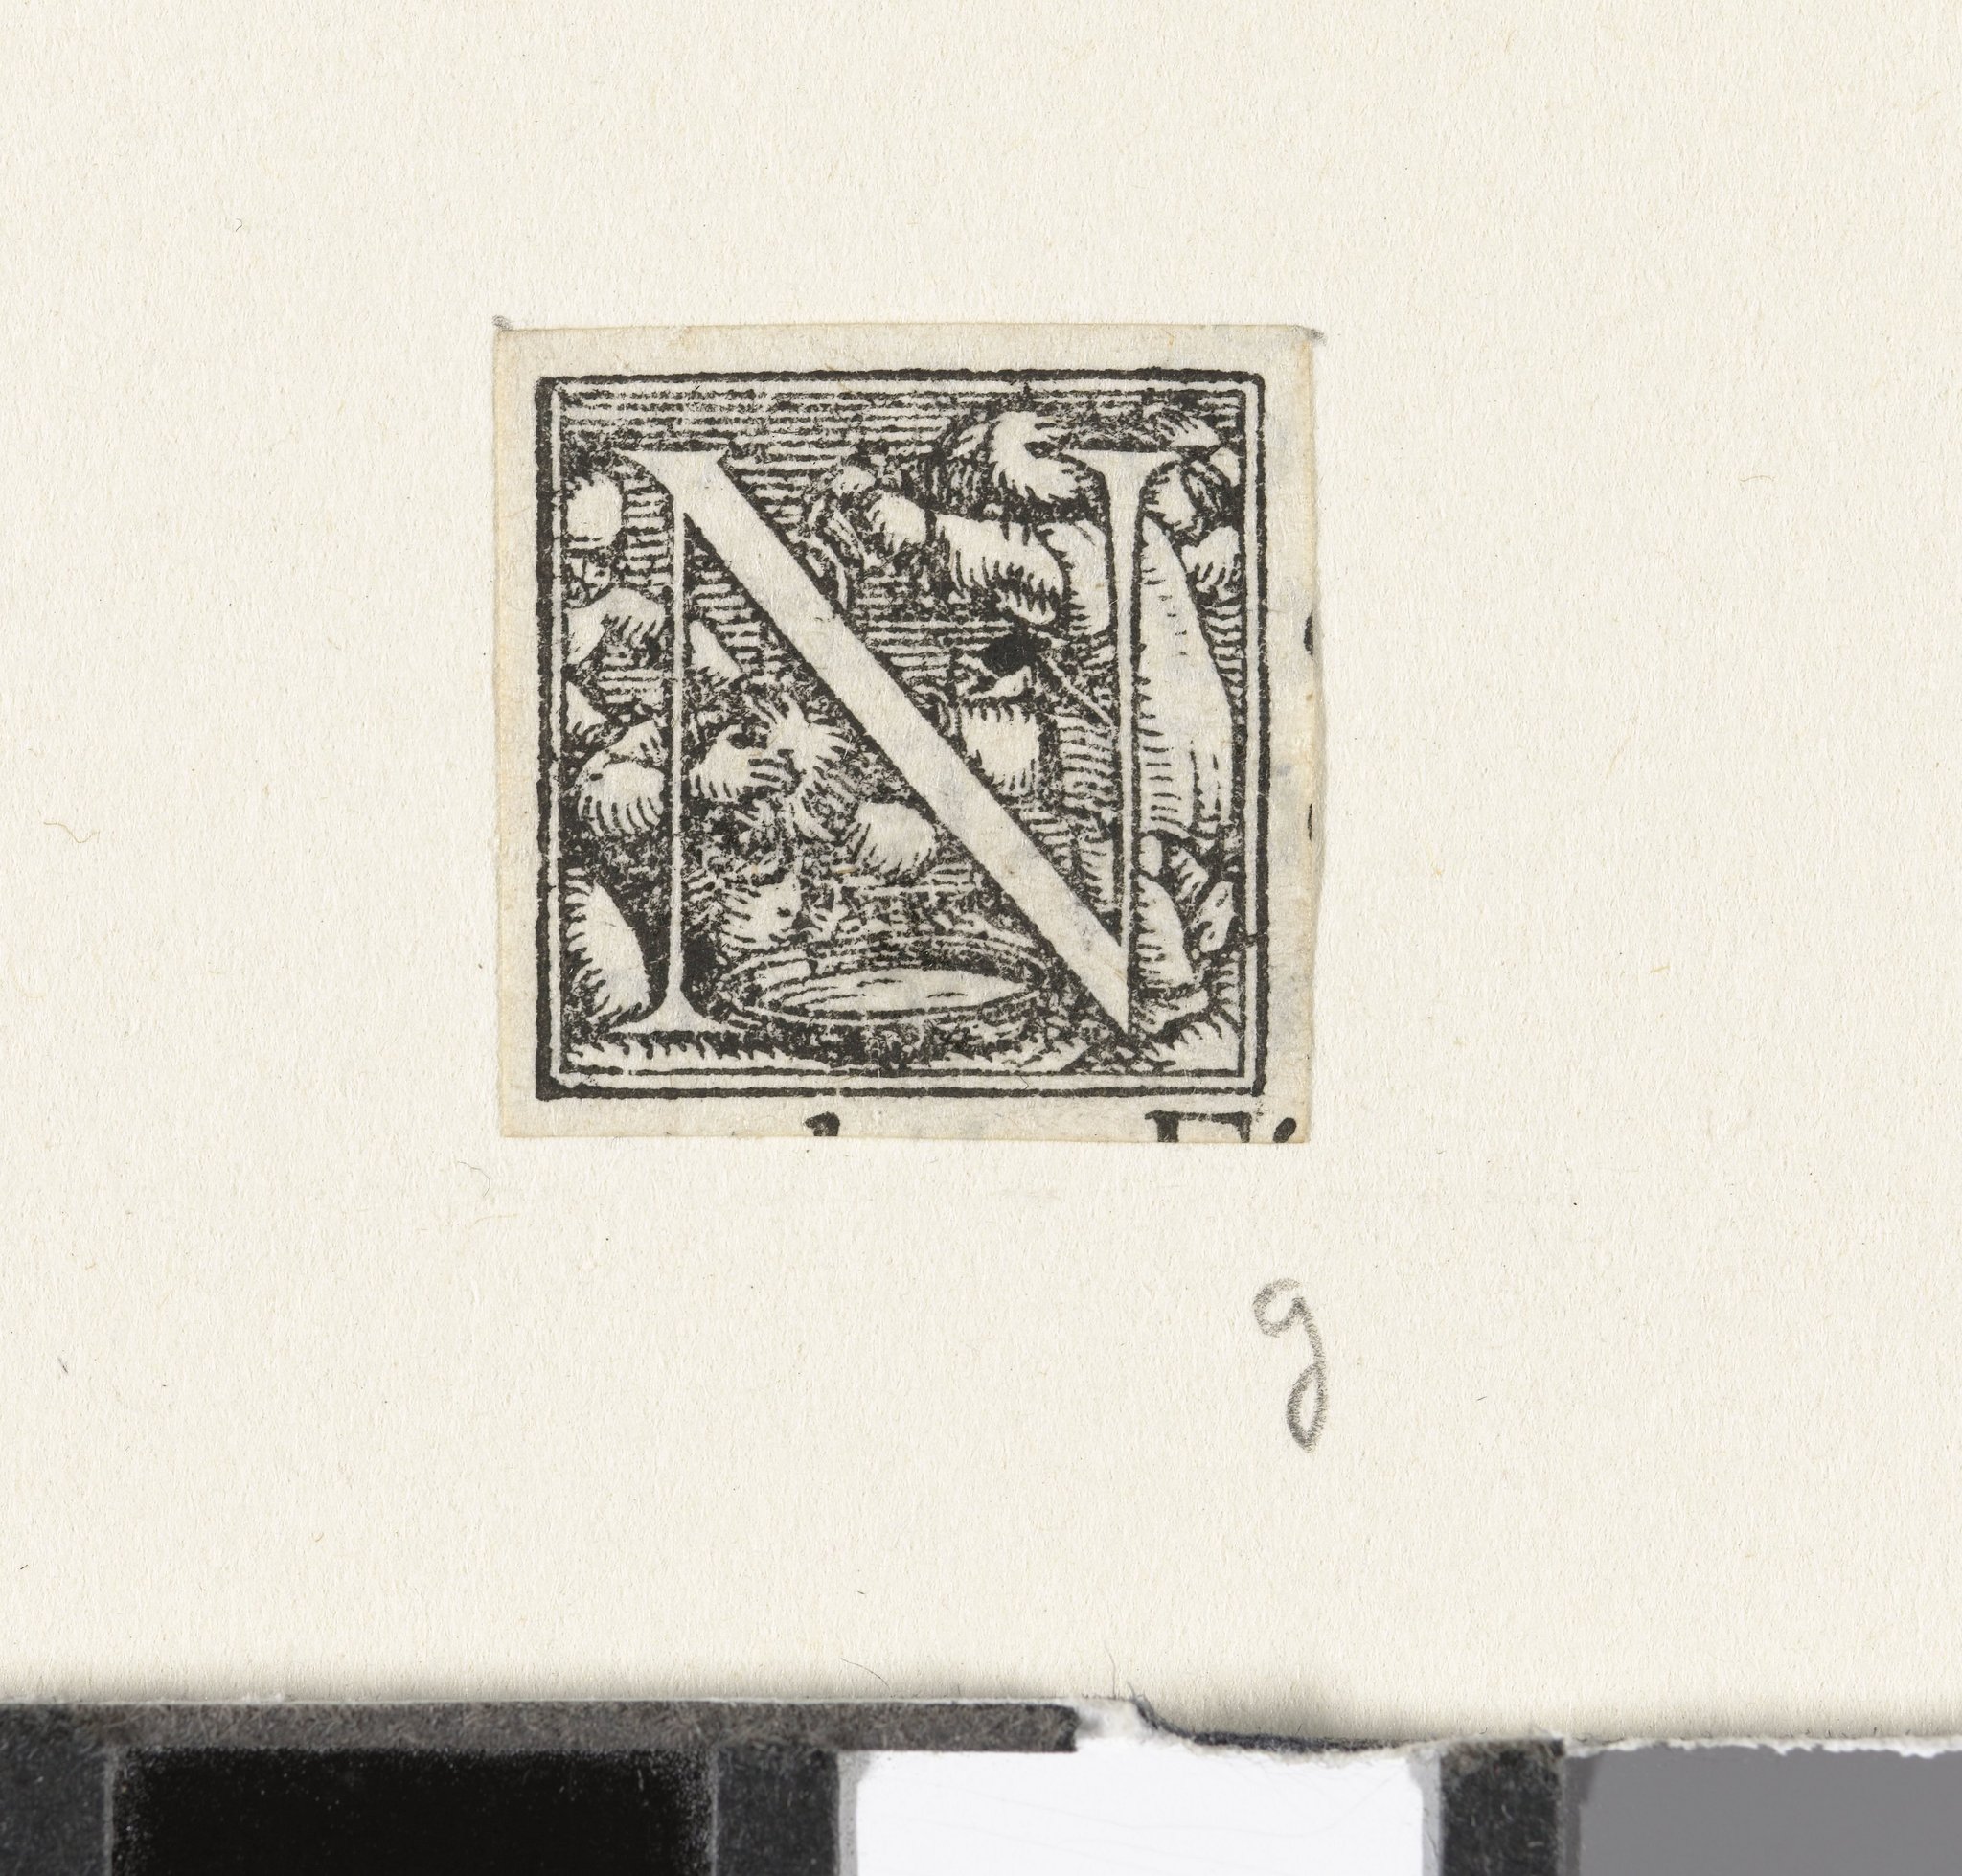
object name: print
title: Alfabet met kinderen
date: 1522-1526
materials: paper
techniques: woodcut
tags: letters, alphabet, script, child